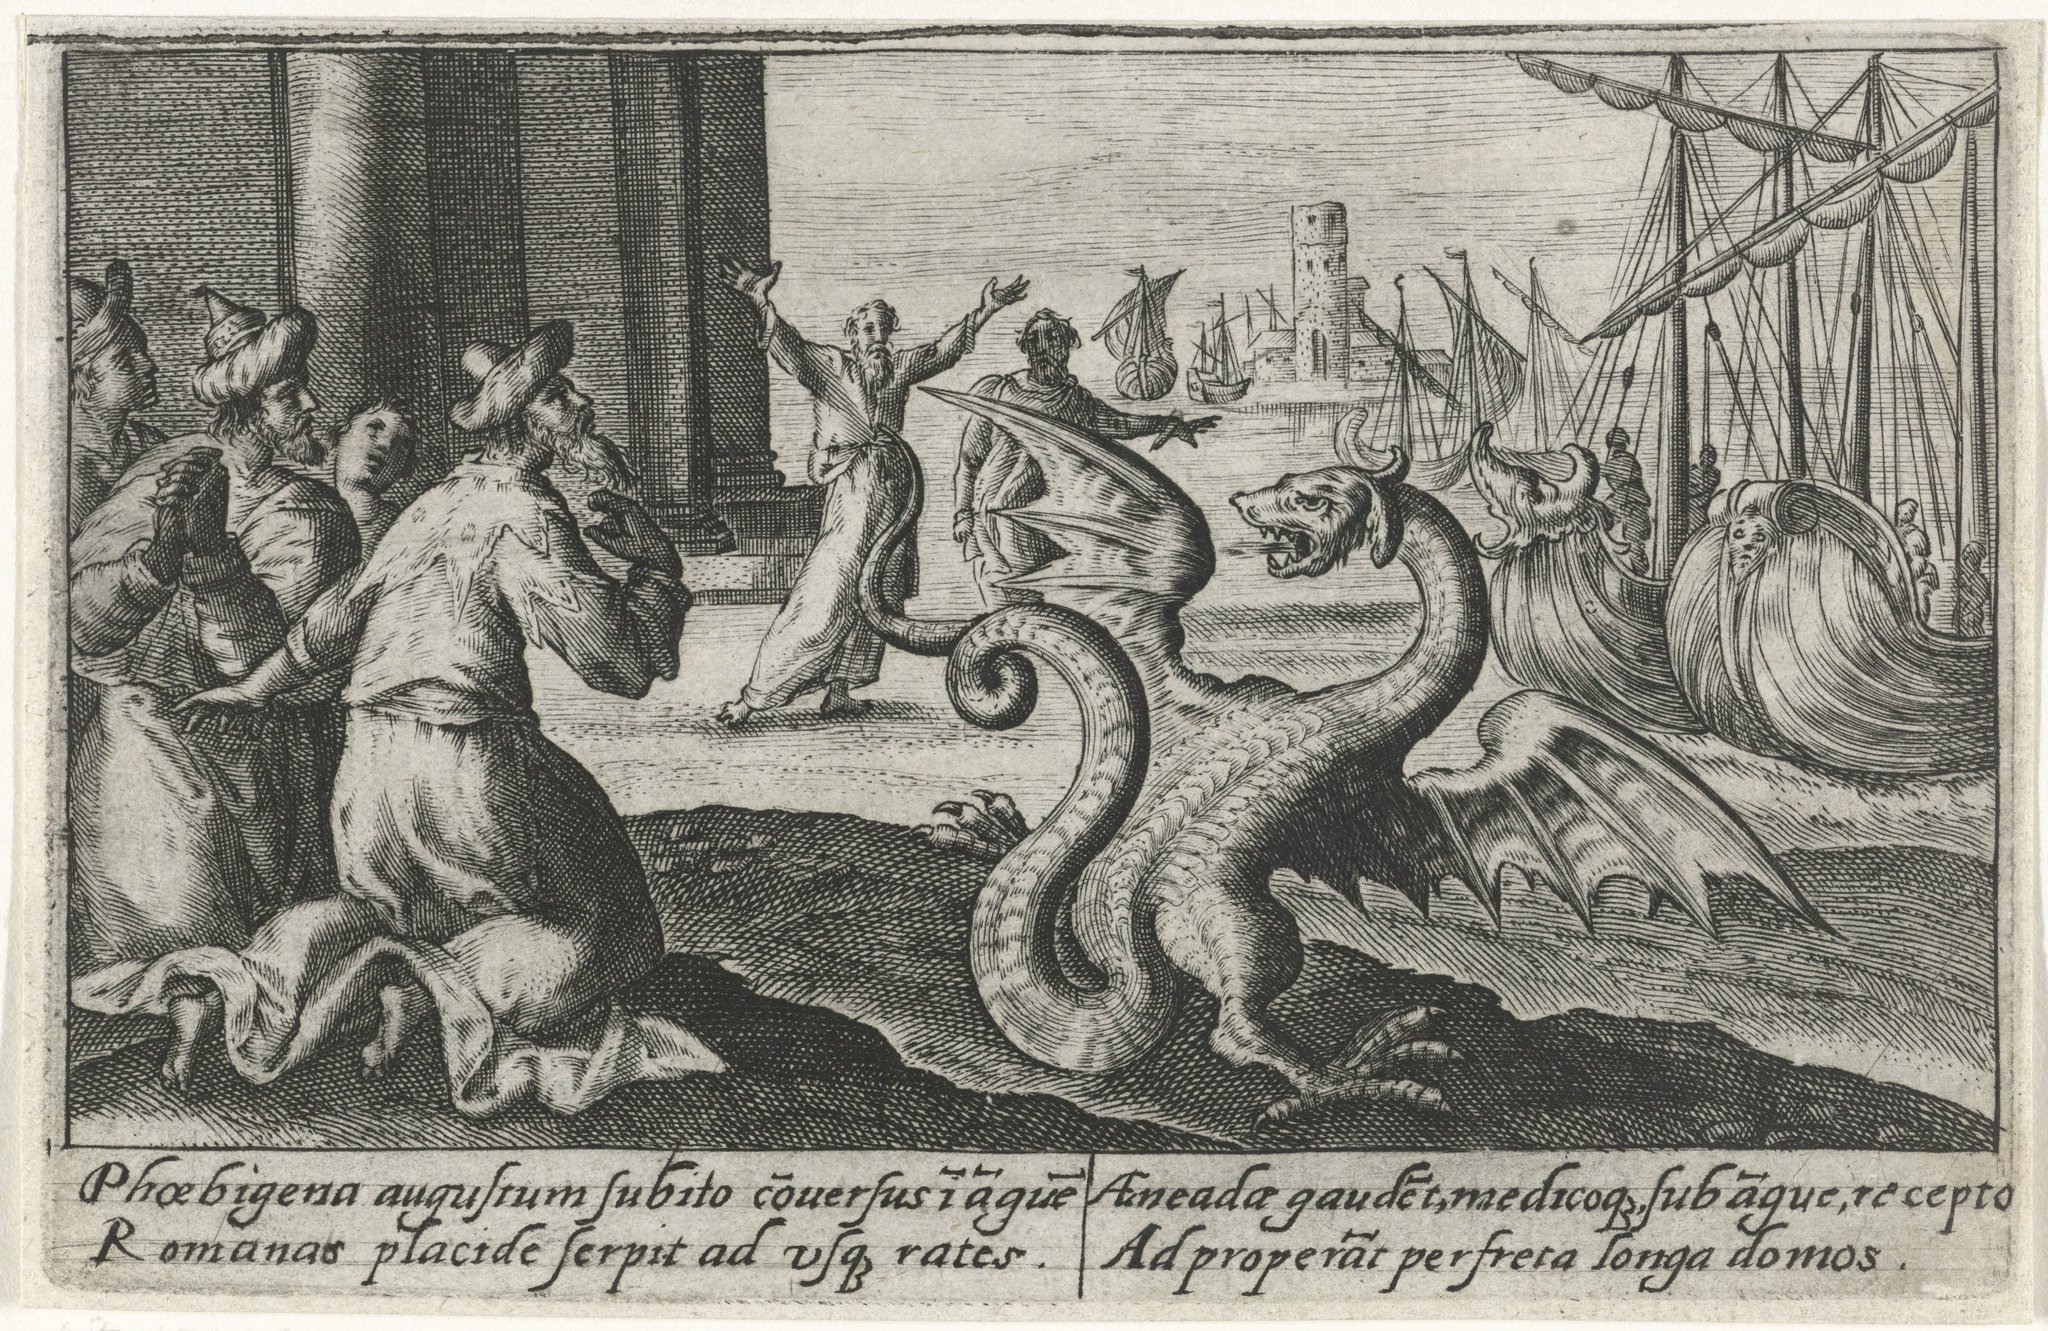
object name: print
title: Aesculapius reist naar Rome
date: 1602-1607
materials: paper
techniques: engraving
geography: cologne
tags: aesculapius transforms himself into a serpent (or dragon) and leaves epidaurus by ship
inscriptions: collector's mark: Lugt 2228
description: Aesculapius, in de gedaante van een draak, loopt dwars door Epidaurus, naar de haven, om aan boord te gaan van een Romeins schip. In de marge een vierregelig onderschrift, in twee kolommen, in het Latijn.